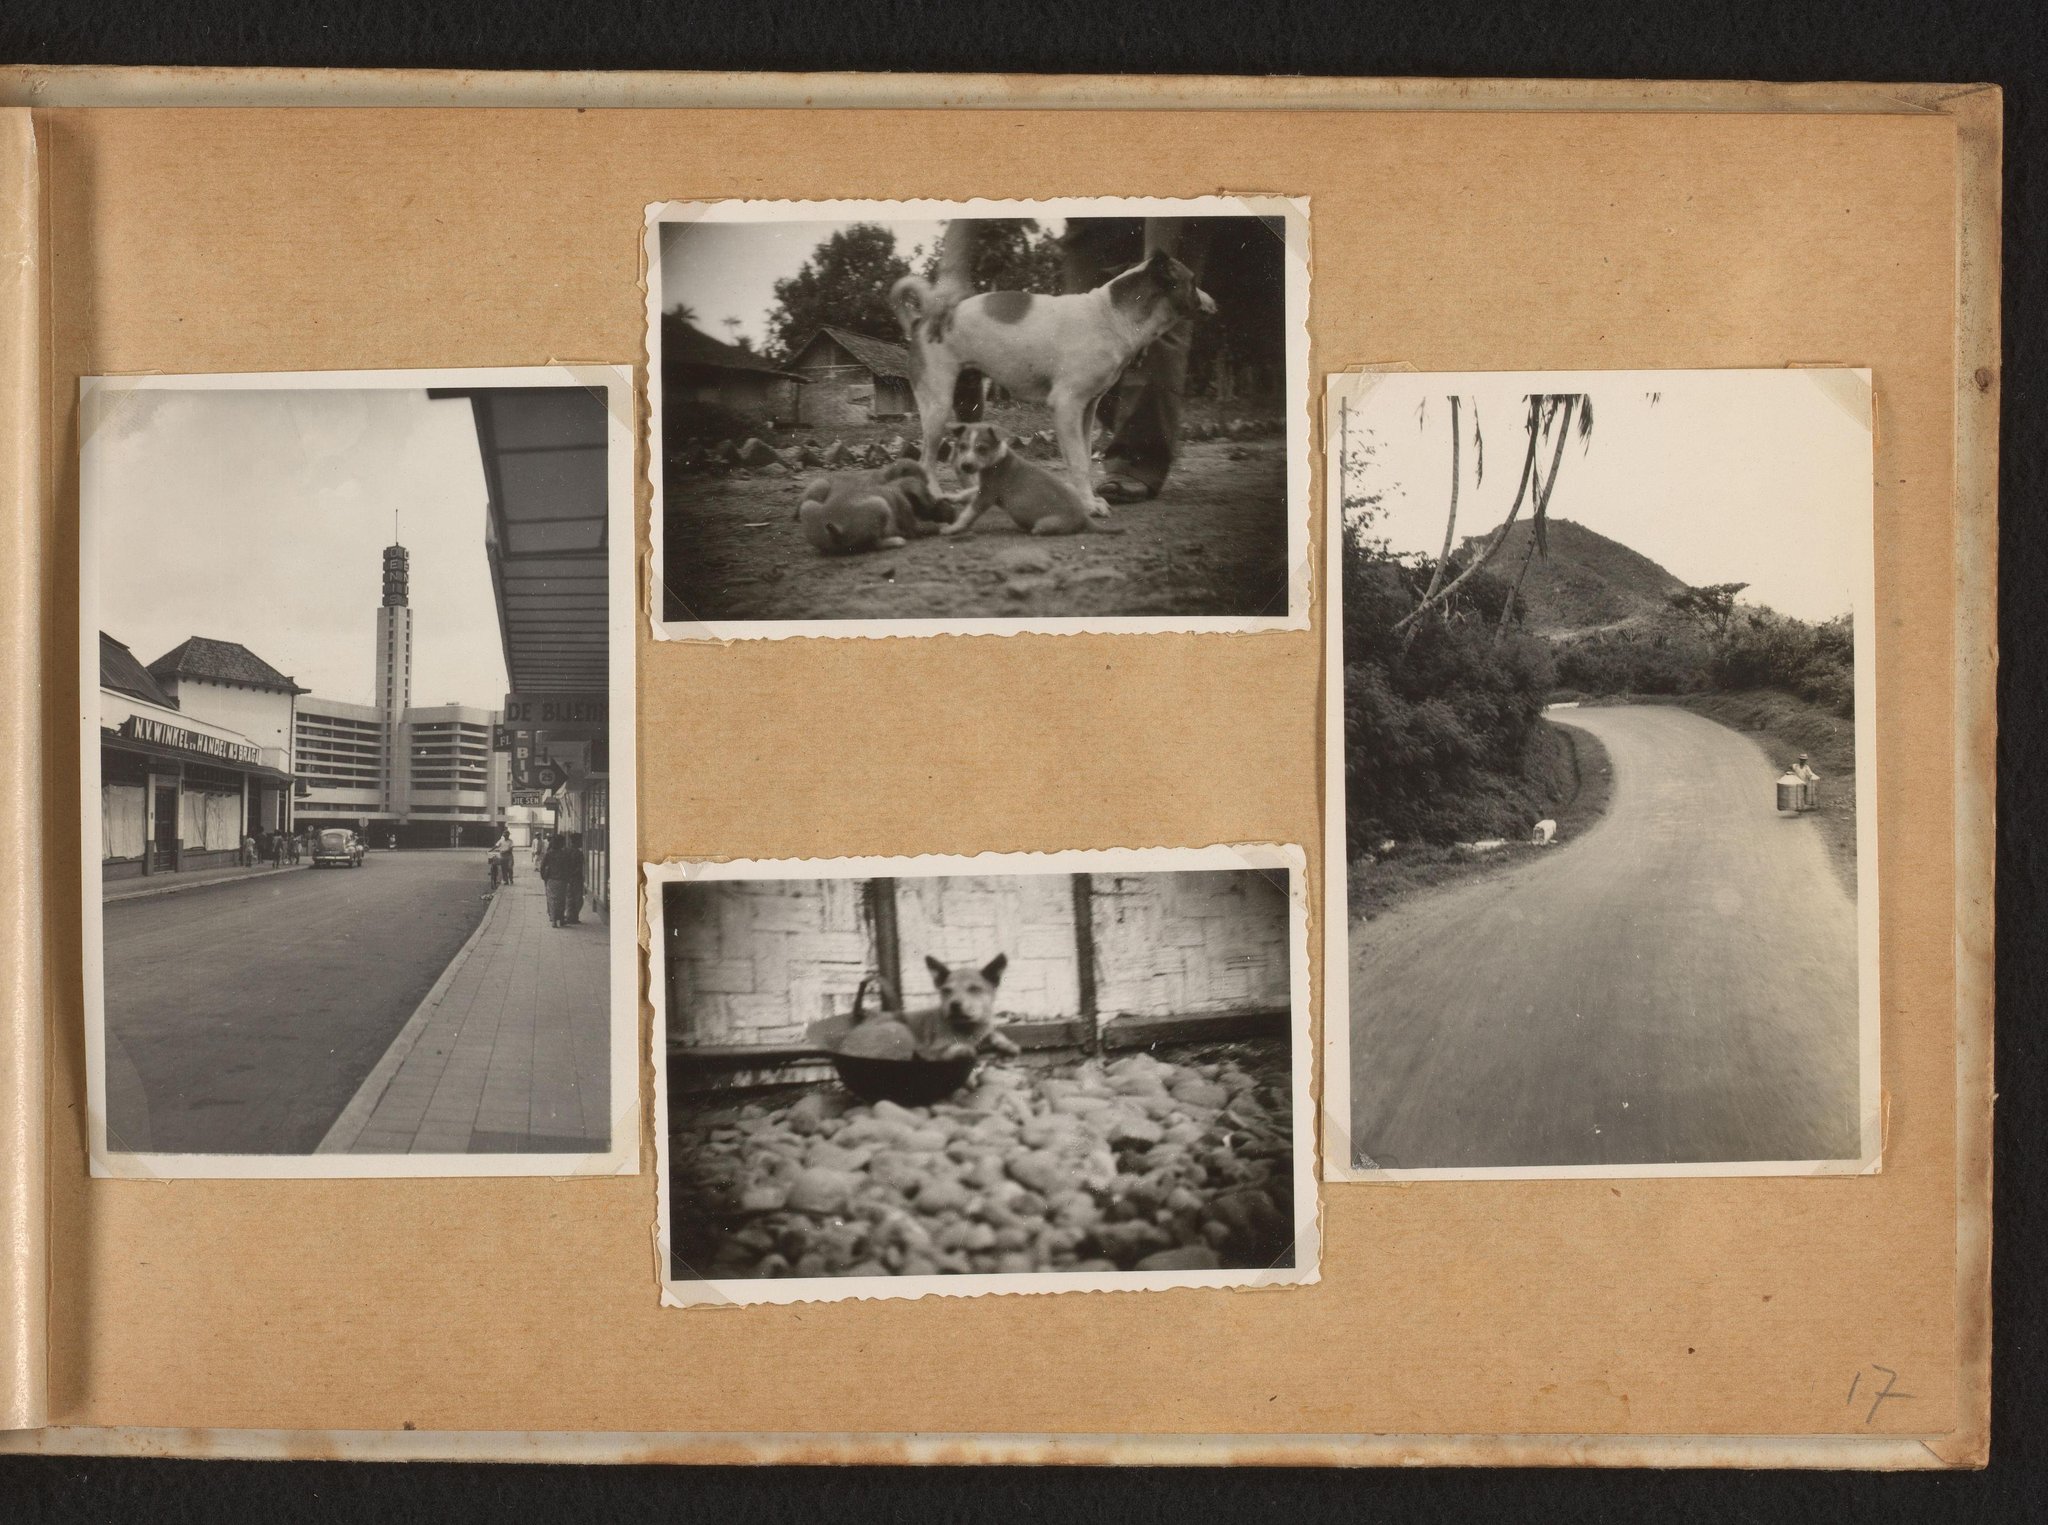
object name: photograph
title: Hond en straatgezicht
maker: Anonymous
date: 1948-1949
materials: cardboard, photographic support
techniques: gelatin silver print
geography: dutch east indies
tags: station; shelter (railway, tramway), barracks, street, dog, dutch east indies, the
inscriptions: inscription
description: Albumblad met vier foto's van een hondje en een straatgezicht in Bandoeng (met de toren van het D.E.N.I.S. gebouw). Onderdeel van het fotoalbum 'Ter herinnering aan mijn diensttijd overzee' 1948-1949.